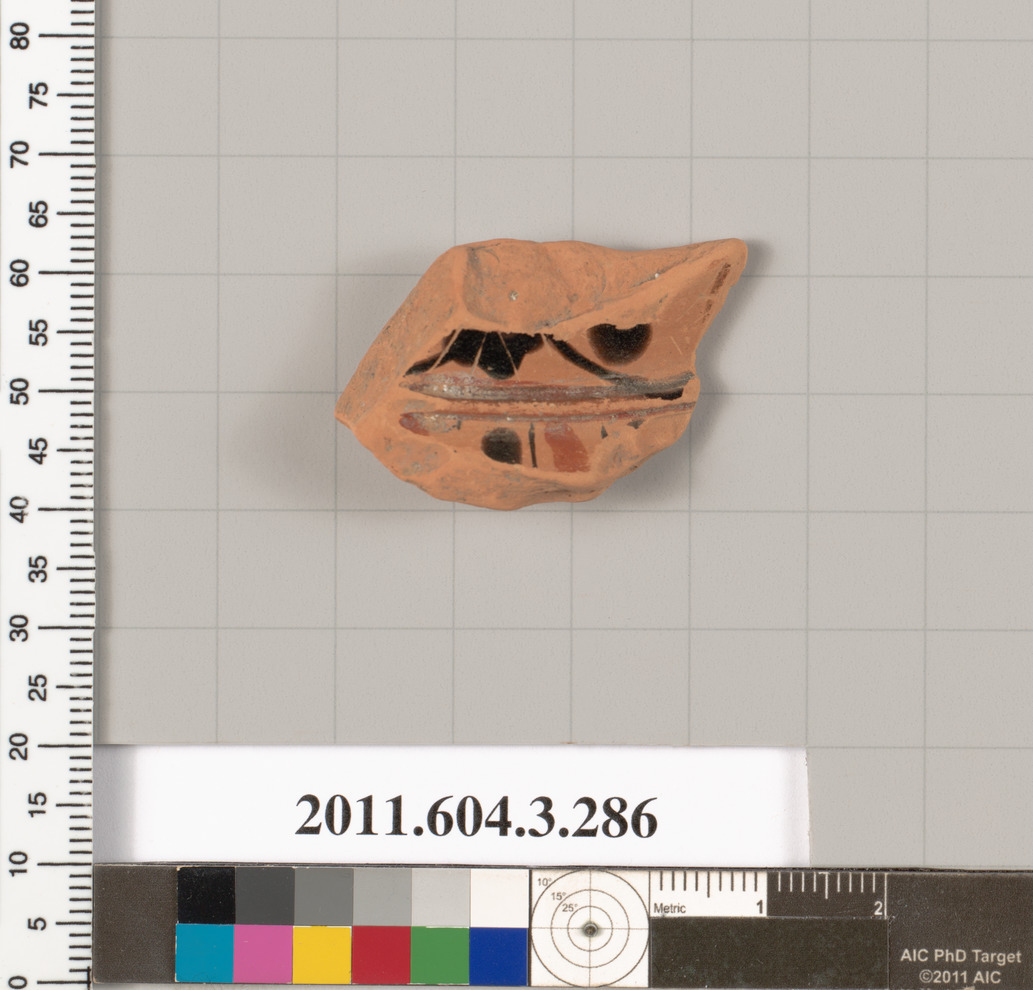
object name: neck amphora fragment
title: Terracotta fragment of a neck-amphora (jar)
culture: greek, attic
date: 530-520 BCE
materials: terracotta